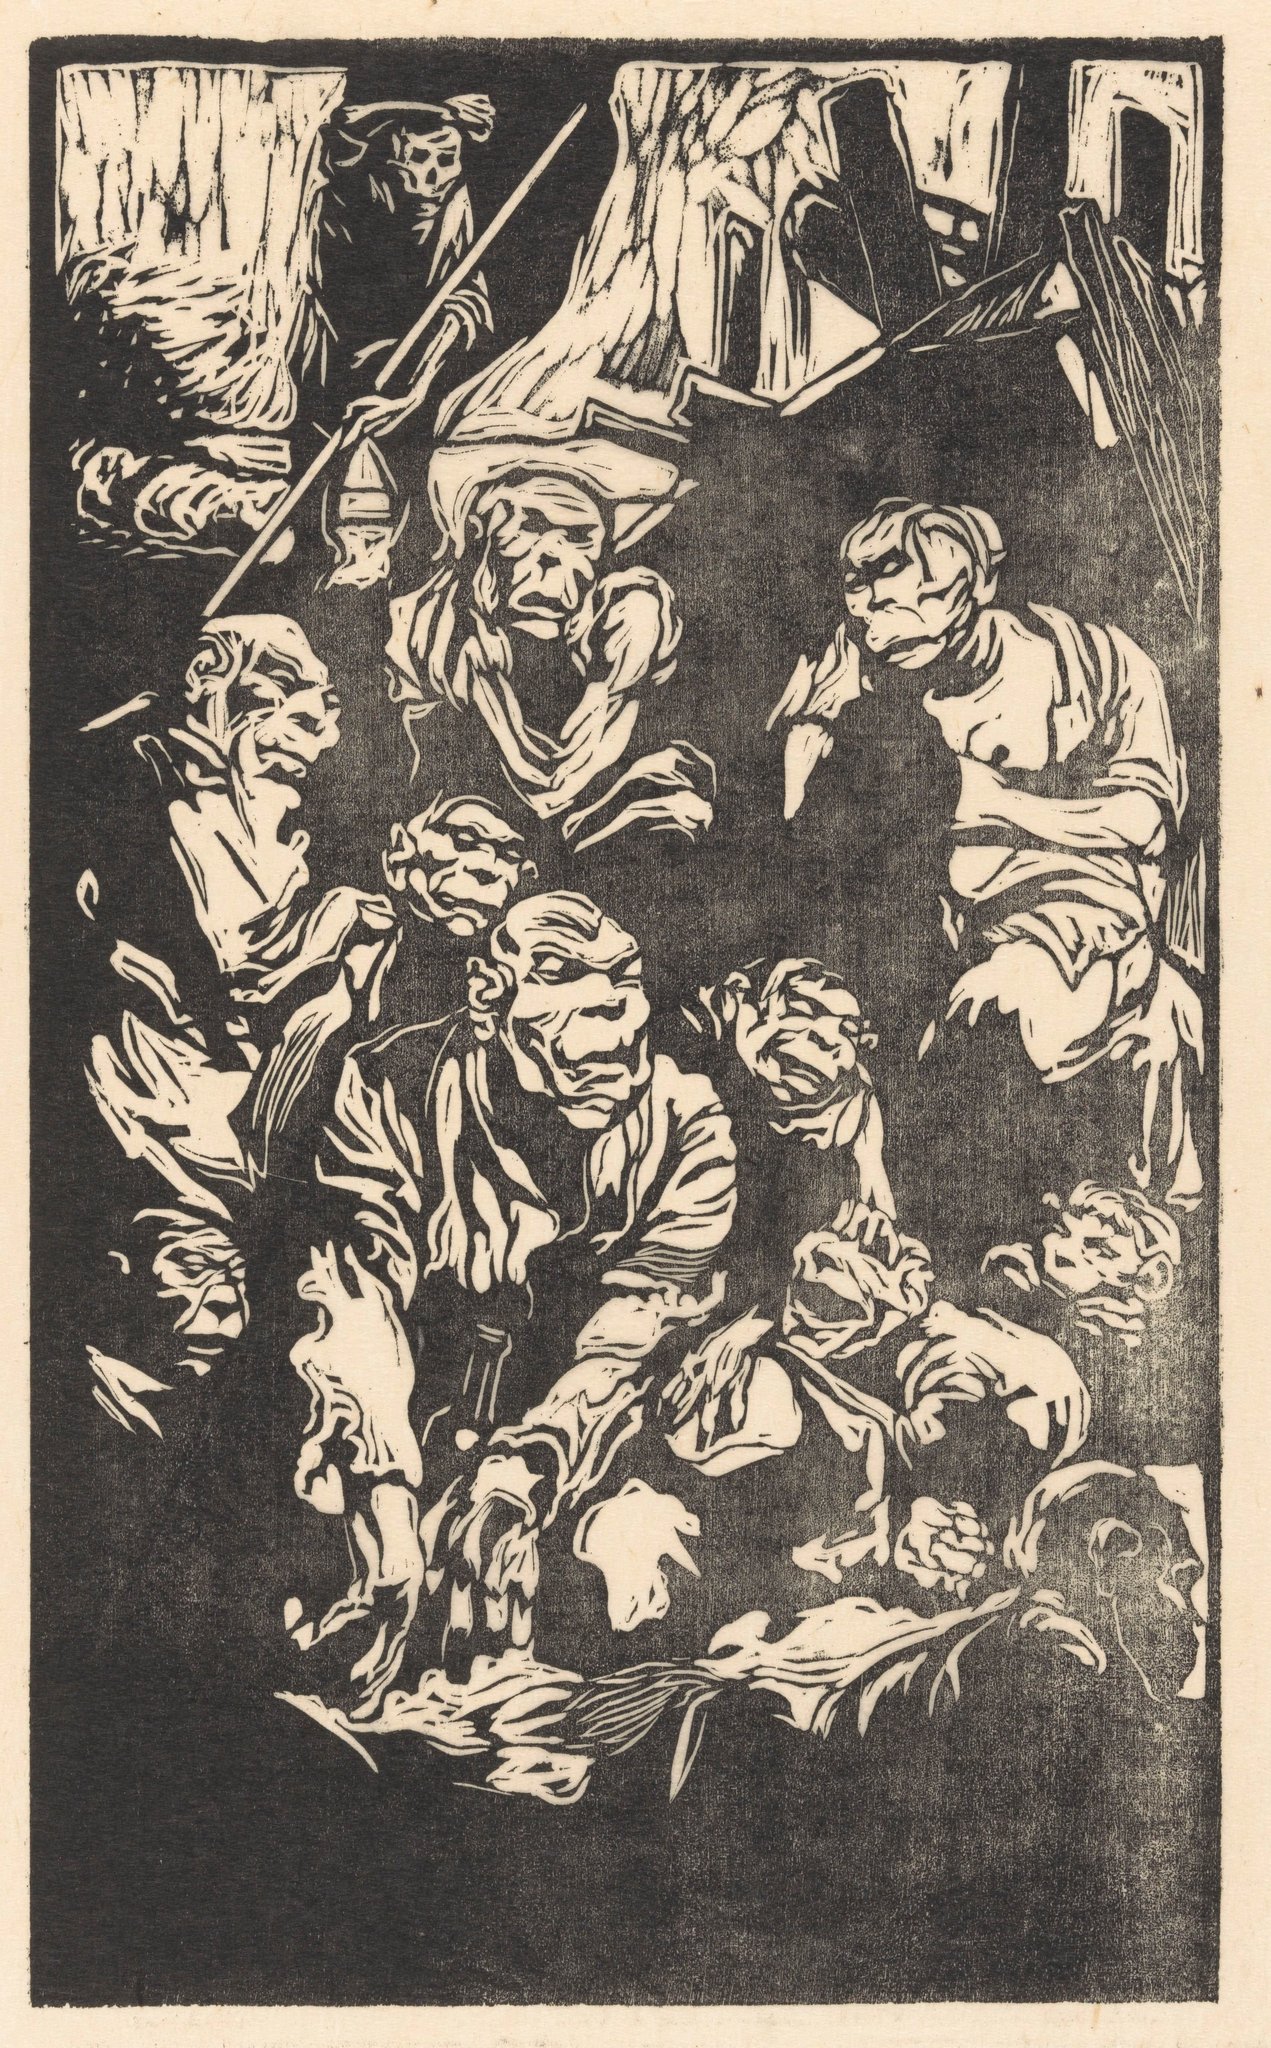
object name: print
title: Fantastische monsters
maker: johannes josephus aarts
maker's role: draughtsman, print maker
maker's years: 1871-1934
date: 1881-1934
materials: paper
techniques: woodcut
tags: surrealia, surrealistic representations, mis-shapen animals; monsters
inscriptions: collector's mark: Lugt 2228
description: Een groep fantasiewezens zit bij elkaar. Een van hen heeft een fles voor zich. Op de achtergrond staat een fantasiewezen met een staaf in zijn hand.